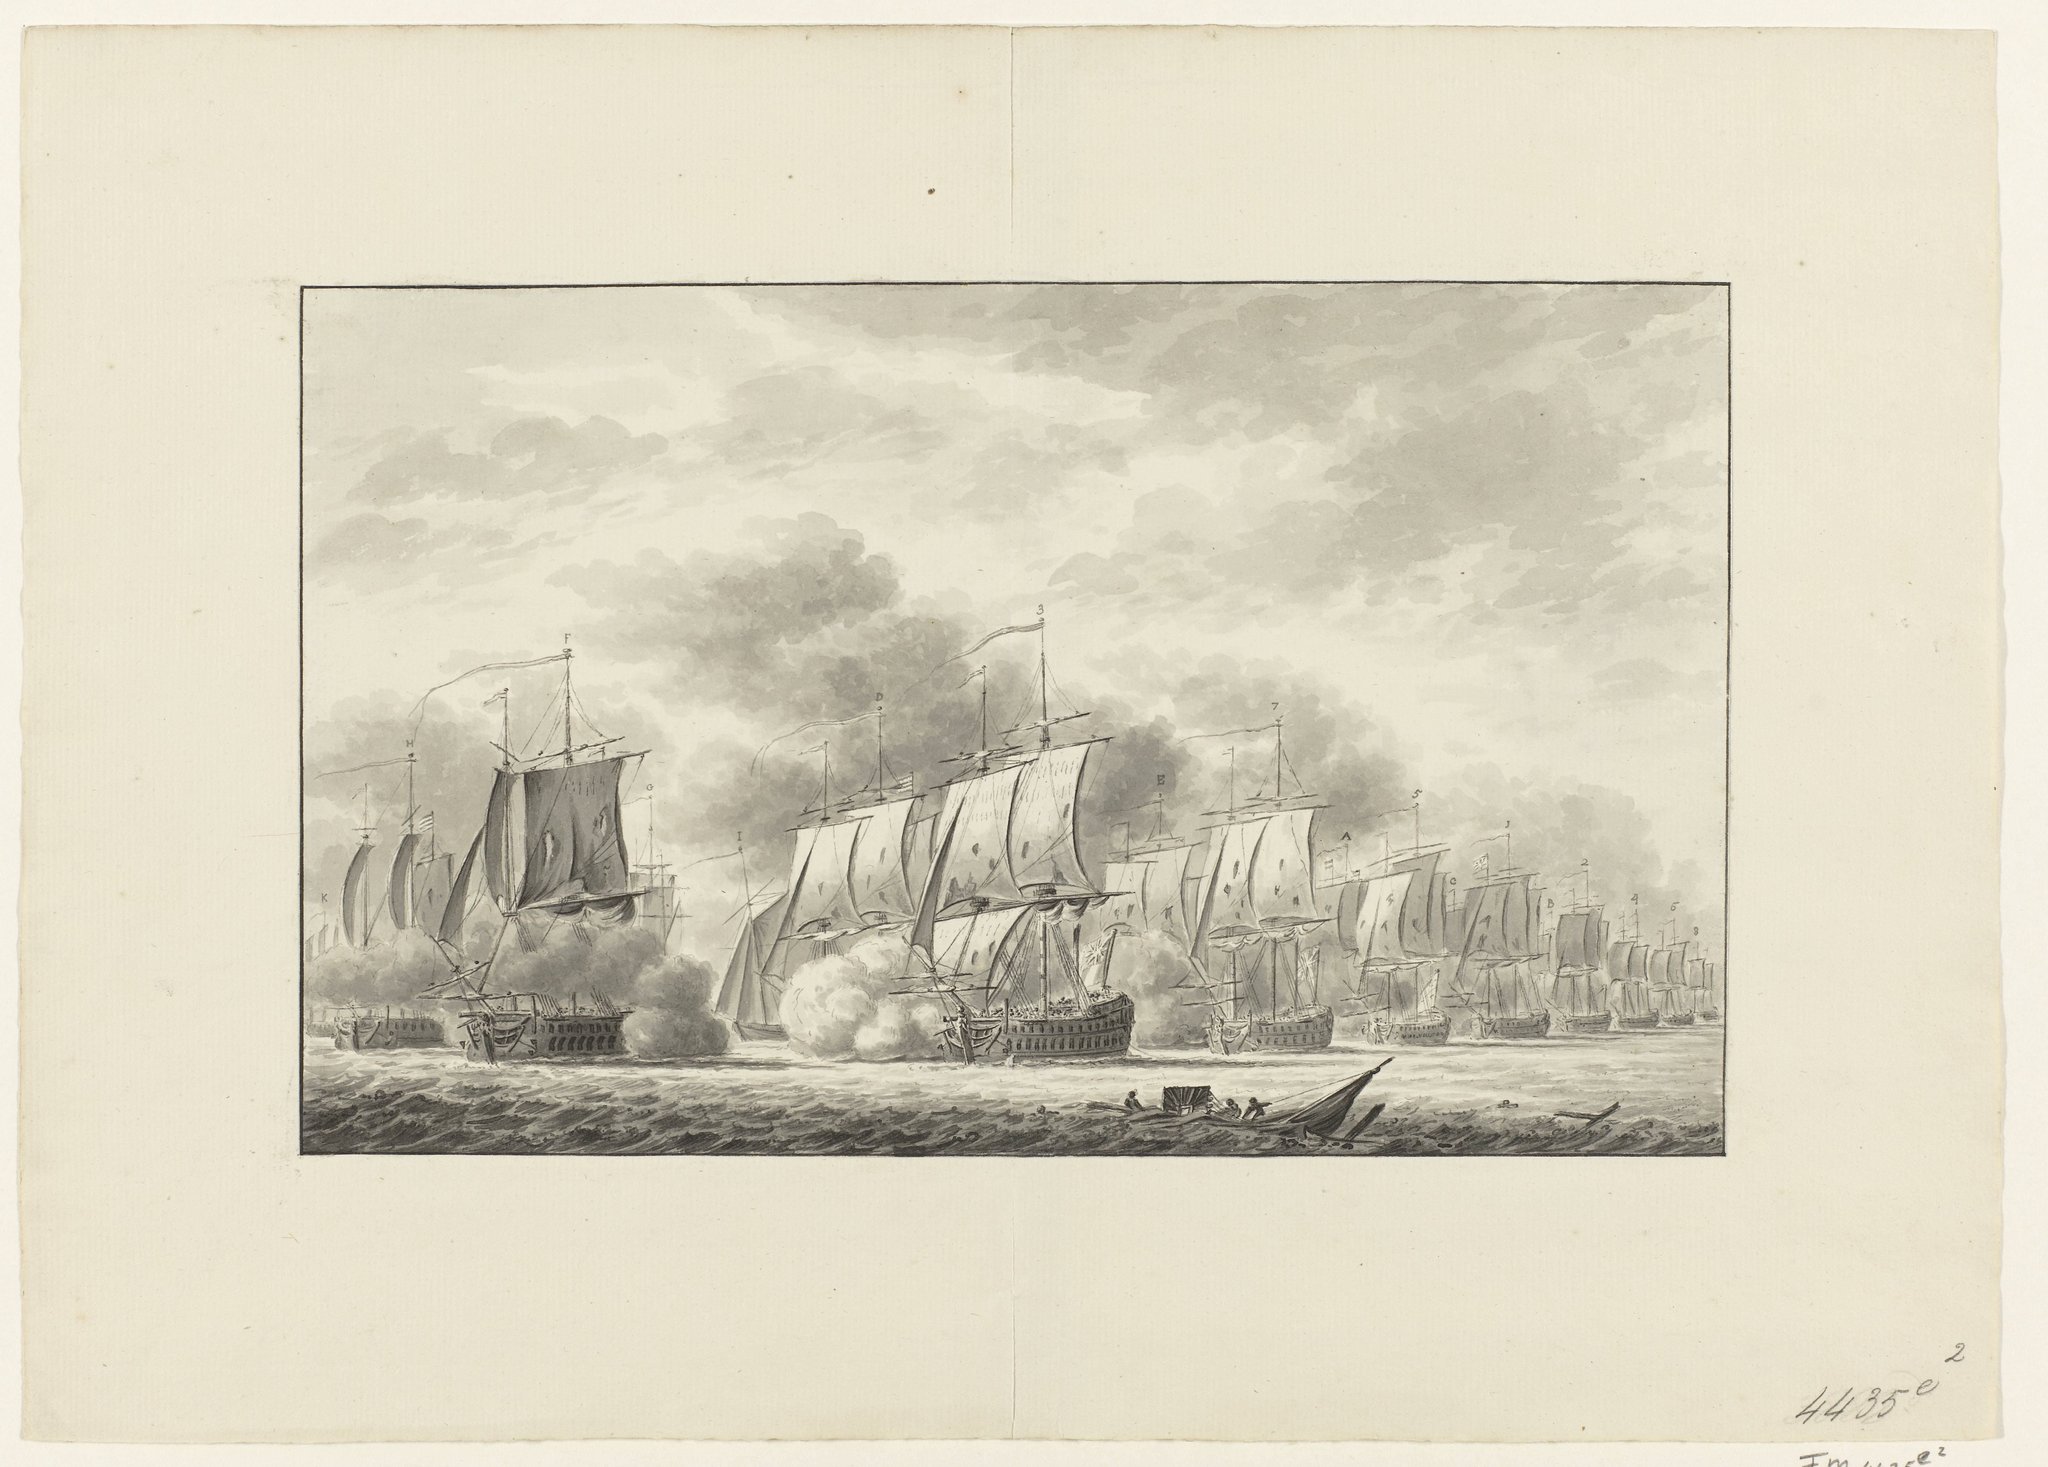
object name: drawing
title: Zeeslag bij Doggersbank, 1781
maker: Anonymous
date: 1781-1784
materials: paper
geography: northern netherlands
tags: the hague, johan arnold zoutman, hyde parker, battle (+ naval force)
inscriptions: collector's mark: Lugt 2228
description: De Nederlandse en Engelse schepen tijdens de zeeslag bij Doggersbank op 5 augustus 1781 tussen de Nederlandse vloot onder schout-bij-nacht Johan Zoutman en de Engelse vloot onder vice-admiraal Hyde Parker.